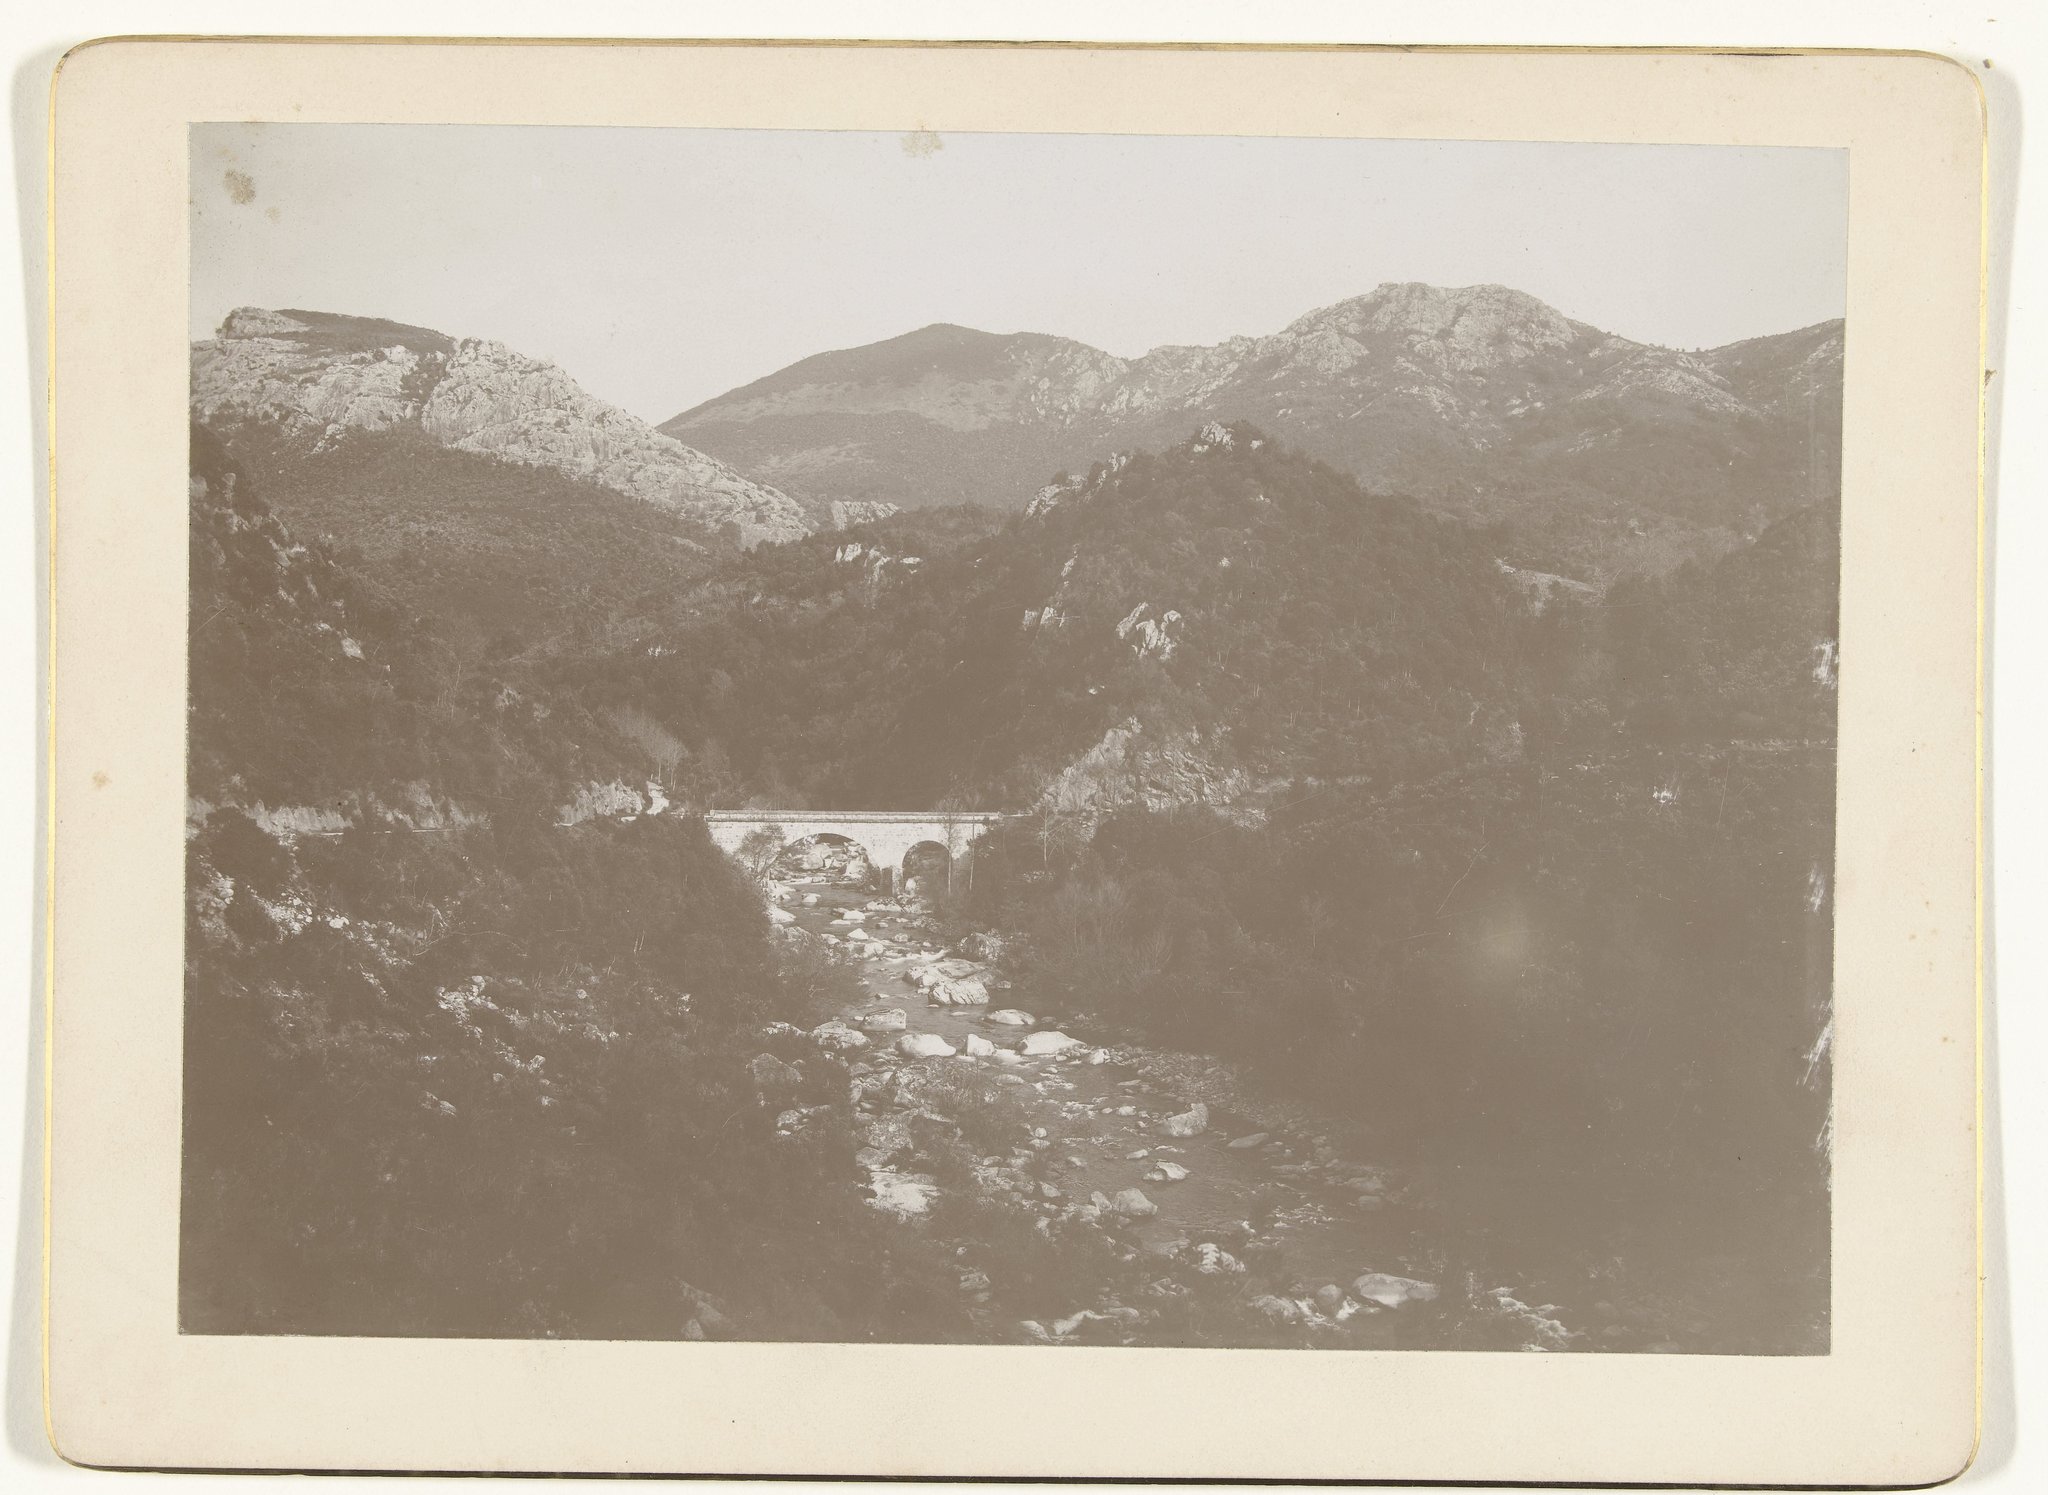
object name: photograph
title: Gezicht op een berglandschap mety brug tussen Cauro en Ajaccio, Corsica, Frankrijk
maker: henry pauw van wieldrecht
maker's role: fotograaf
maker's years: 1863-1912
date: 1896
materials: cardboard, photographic support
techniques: gelatin silver print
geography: france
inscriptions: annotation: ‘No. 1181. 1896.’